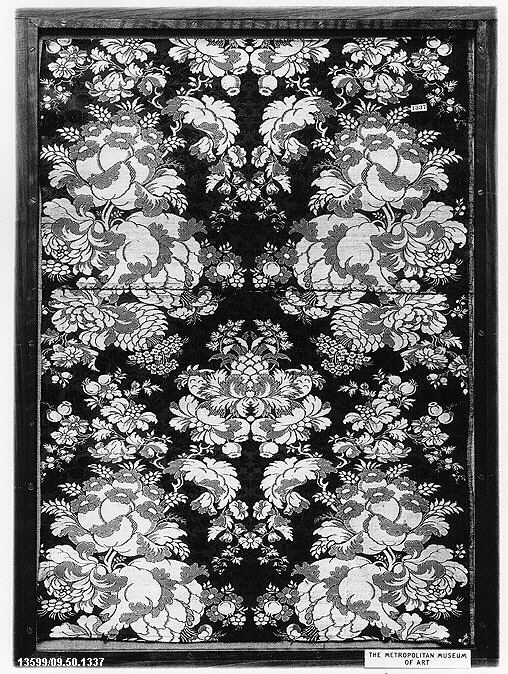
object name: piece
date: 1730-1735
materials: silk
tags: flowers,leaves